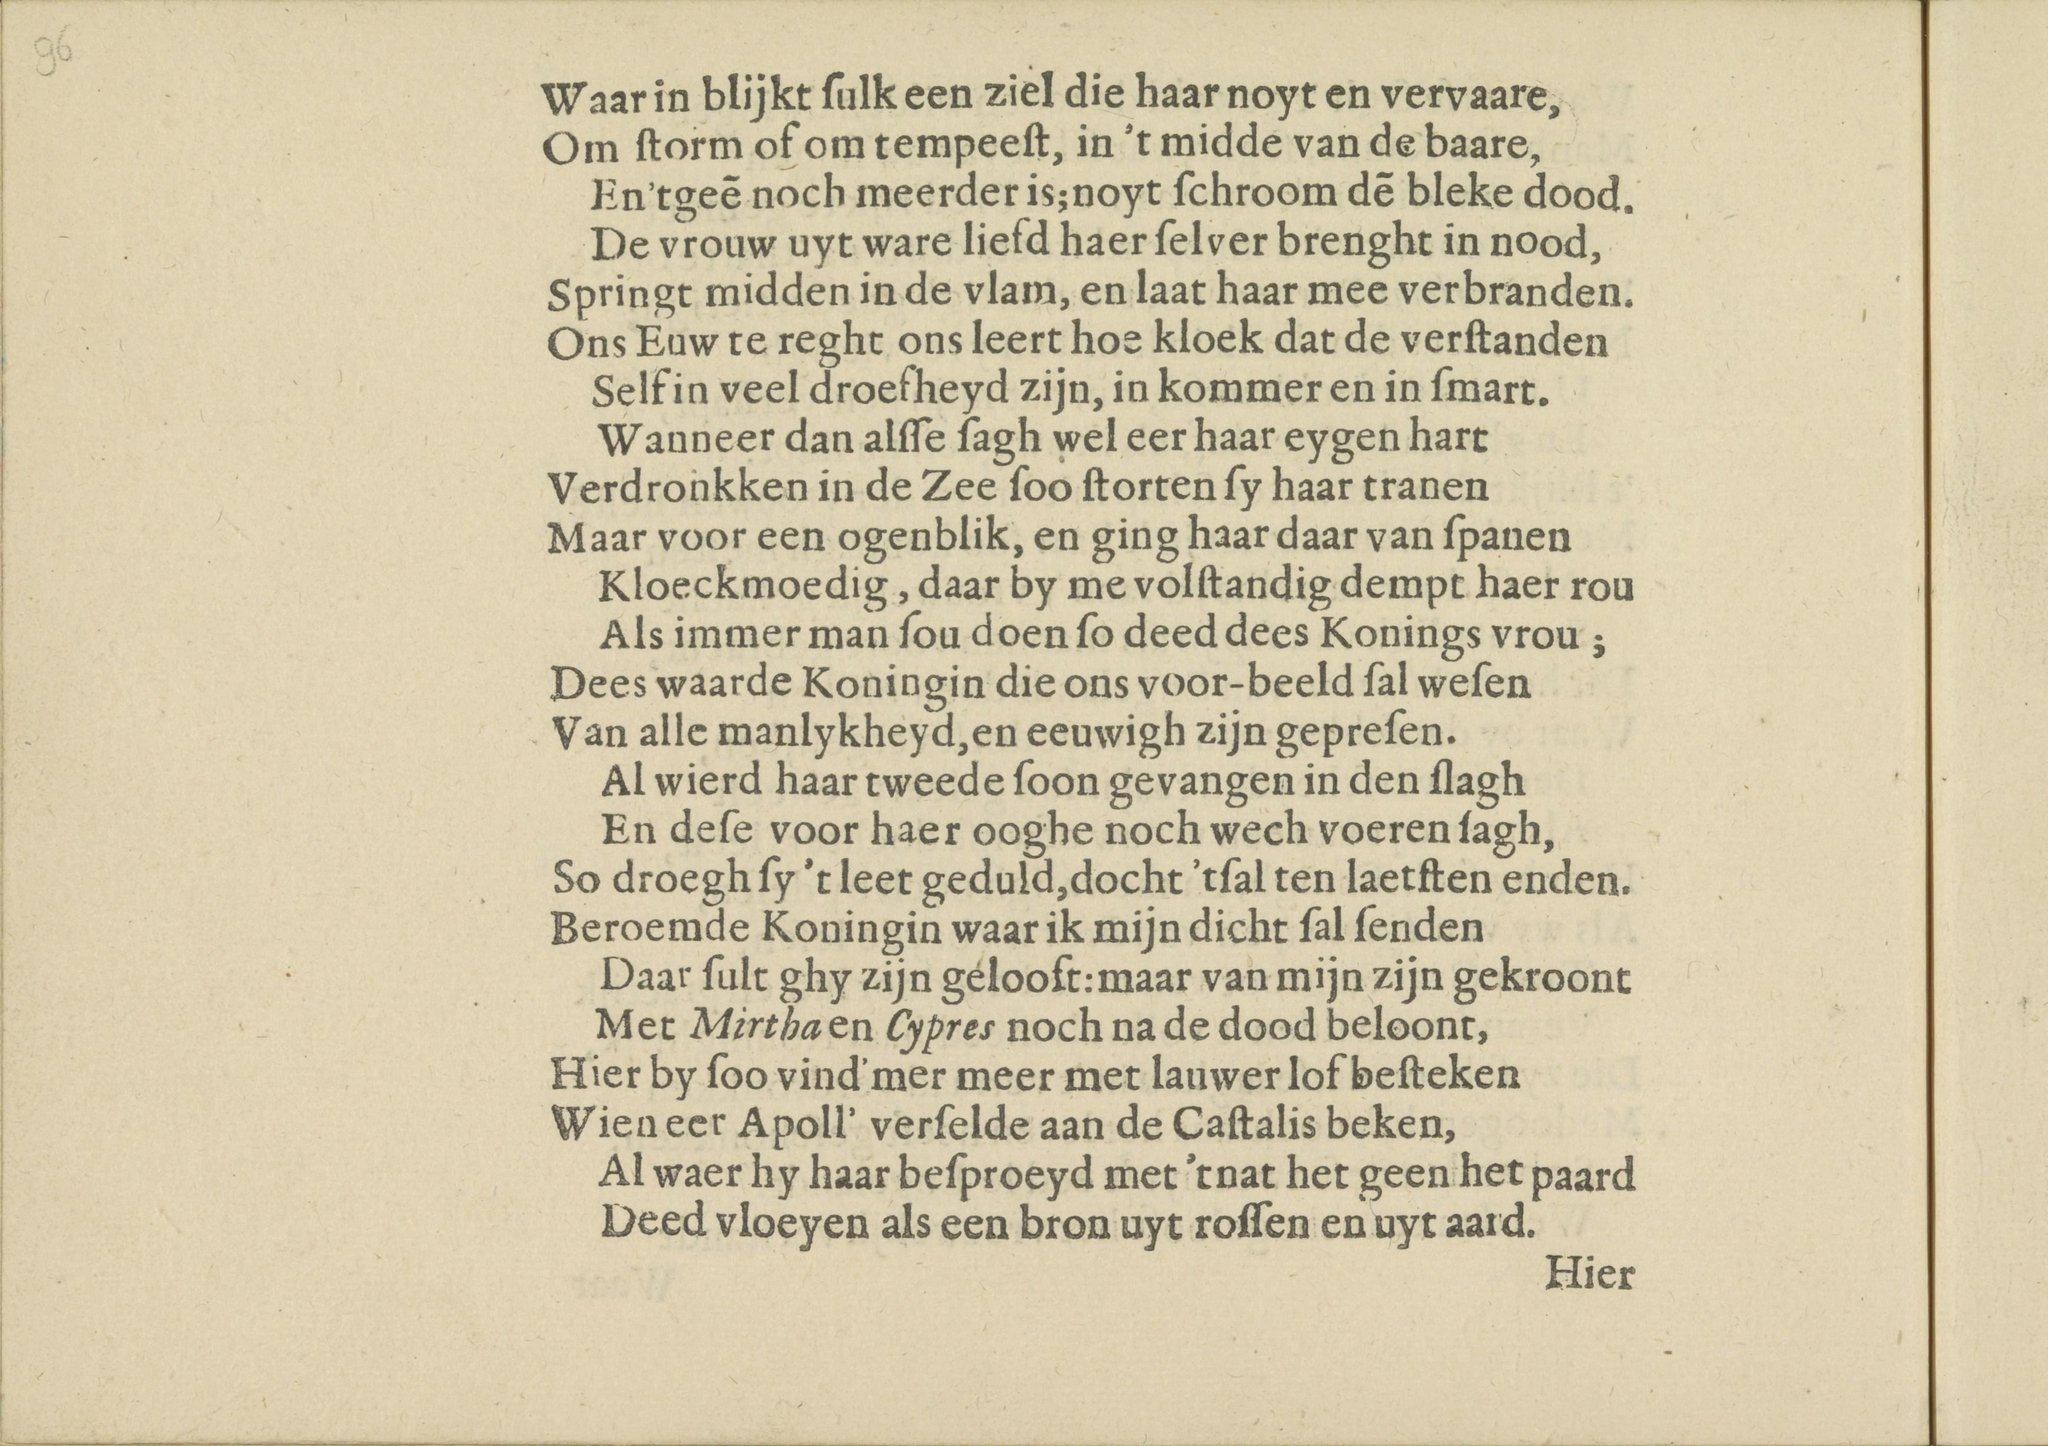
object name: text sheet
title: Aen de Nimphies vanden Amstel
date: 1640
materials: paper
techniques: letterpress printing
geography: amsterdam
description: Nederlandstalig gedicht op de Nimfen van de Amstel op elf pagina's: pagina 5. Het blad maakt deel uit van een album.